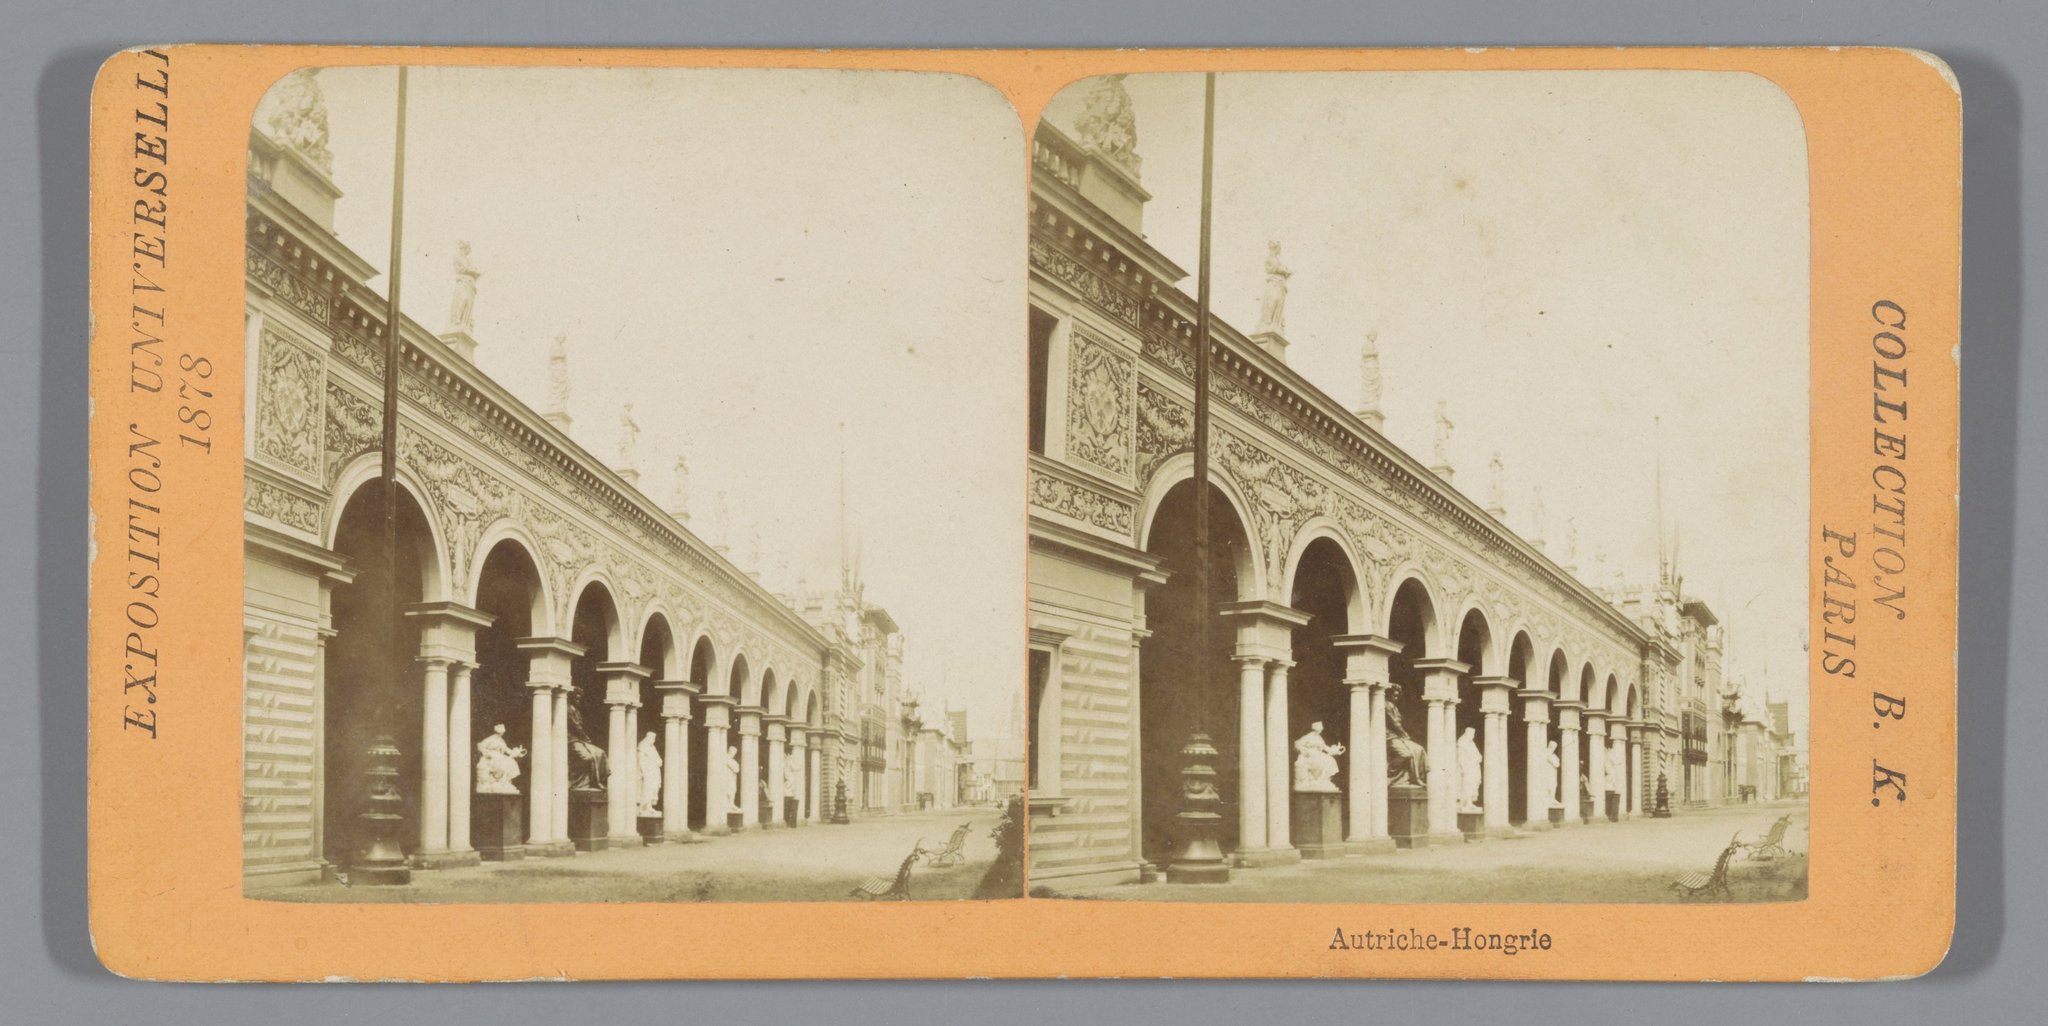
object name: stereograph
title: Exposition Universelle 1878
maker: adolphe block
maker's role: publisher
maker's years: 1829-1918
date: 1878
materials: cardboard, paper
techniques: albumen print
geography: paris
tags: world fair, world exhibition, exterior ~ representation of a building, paris